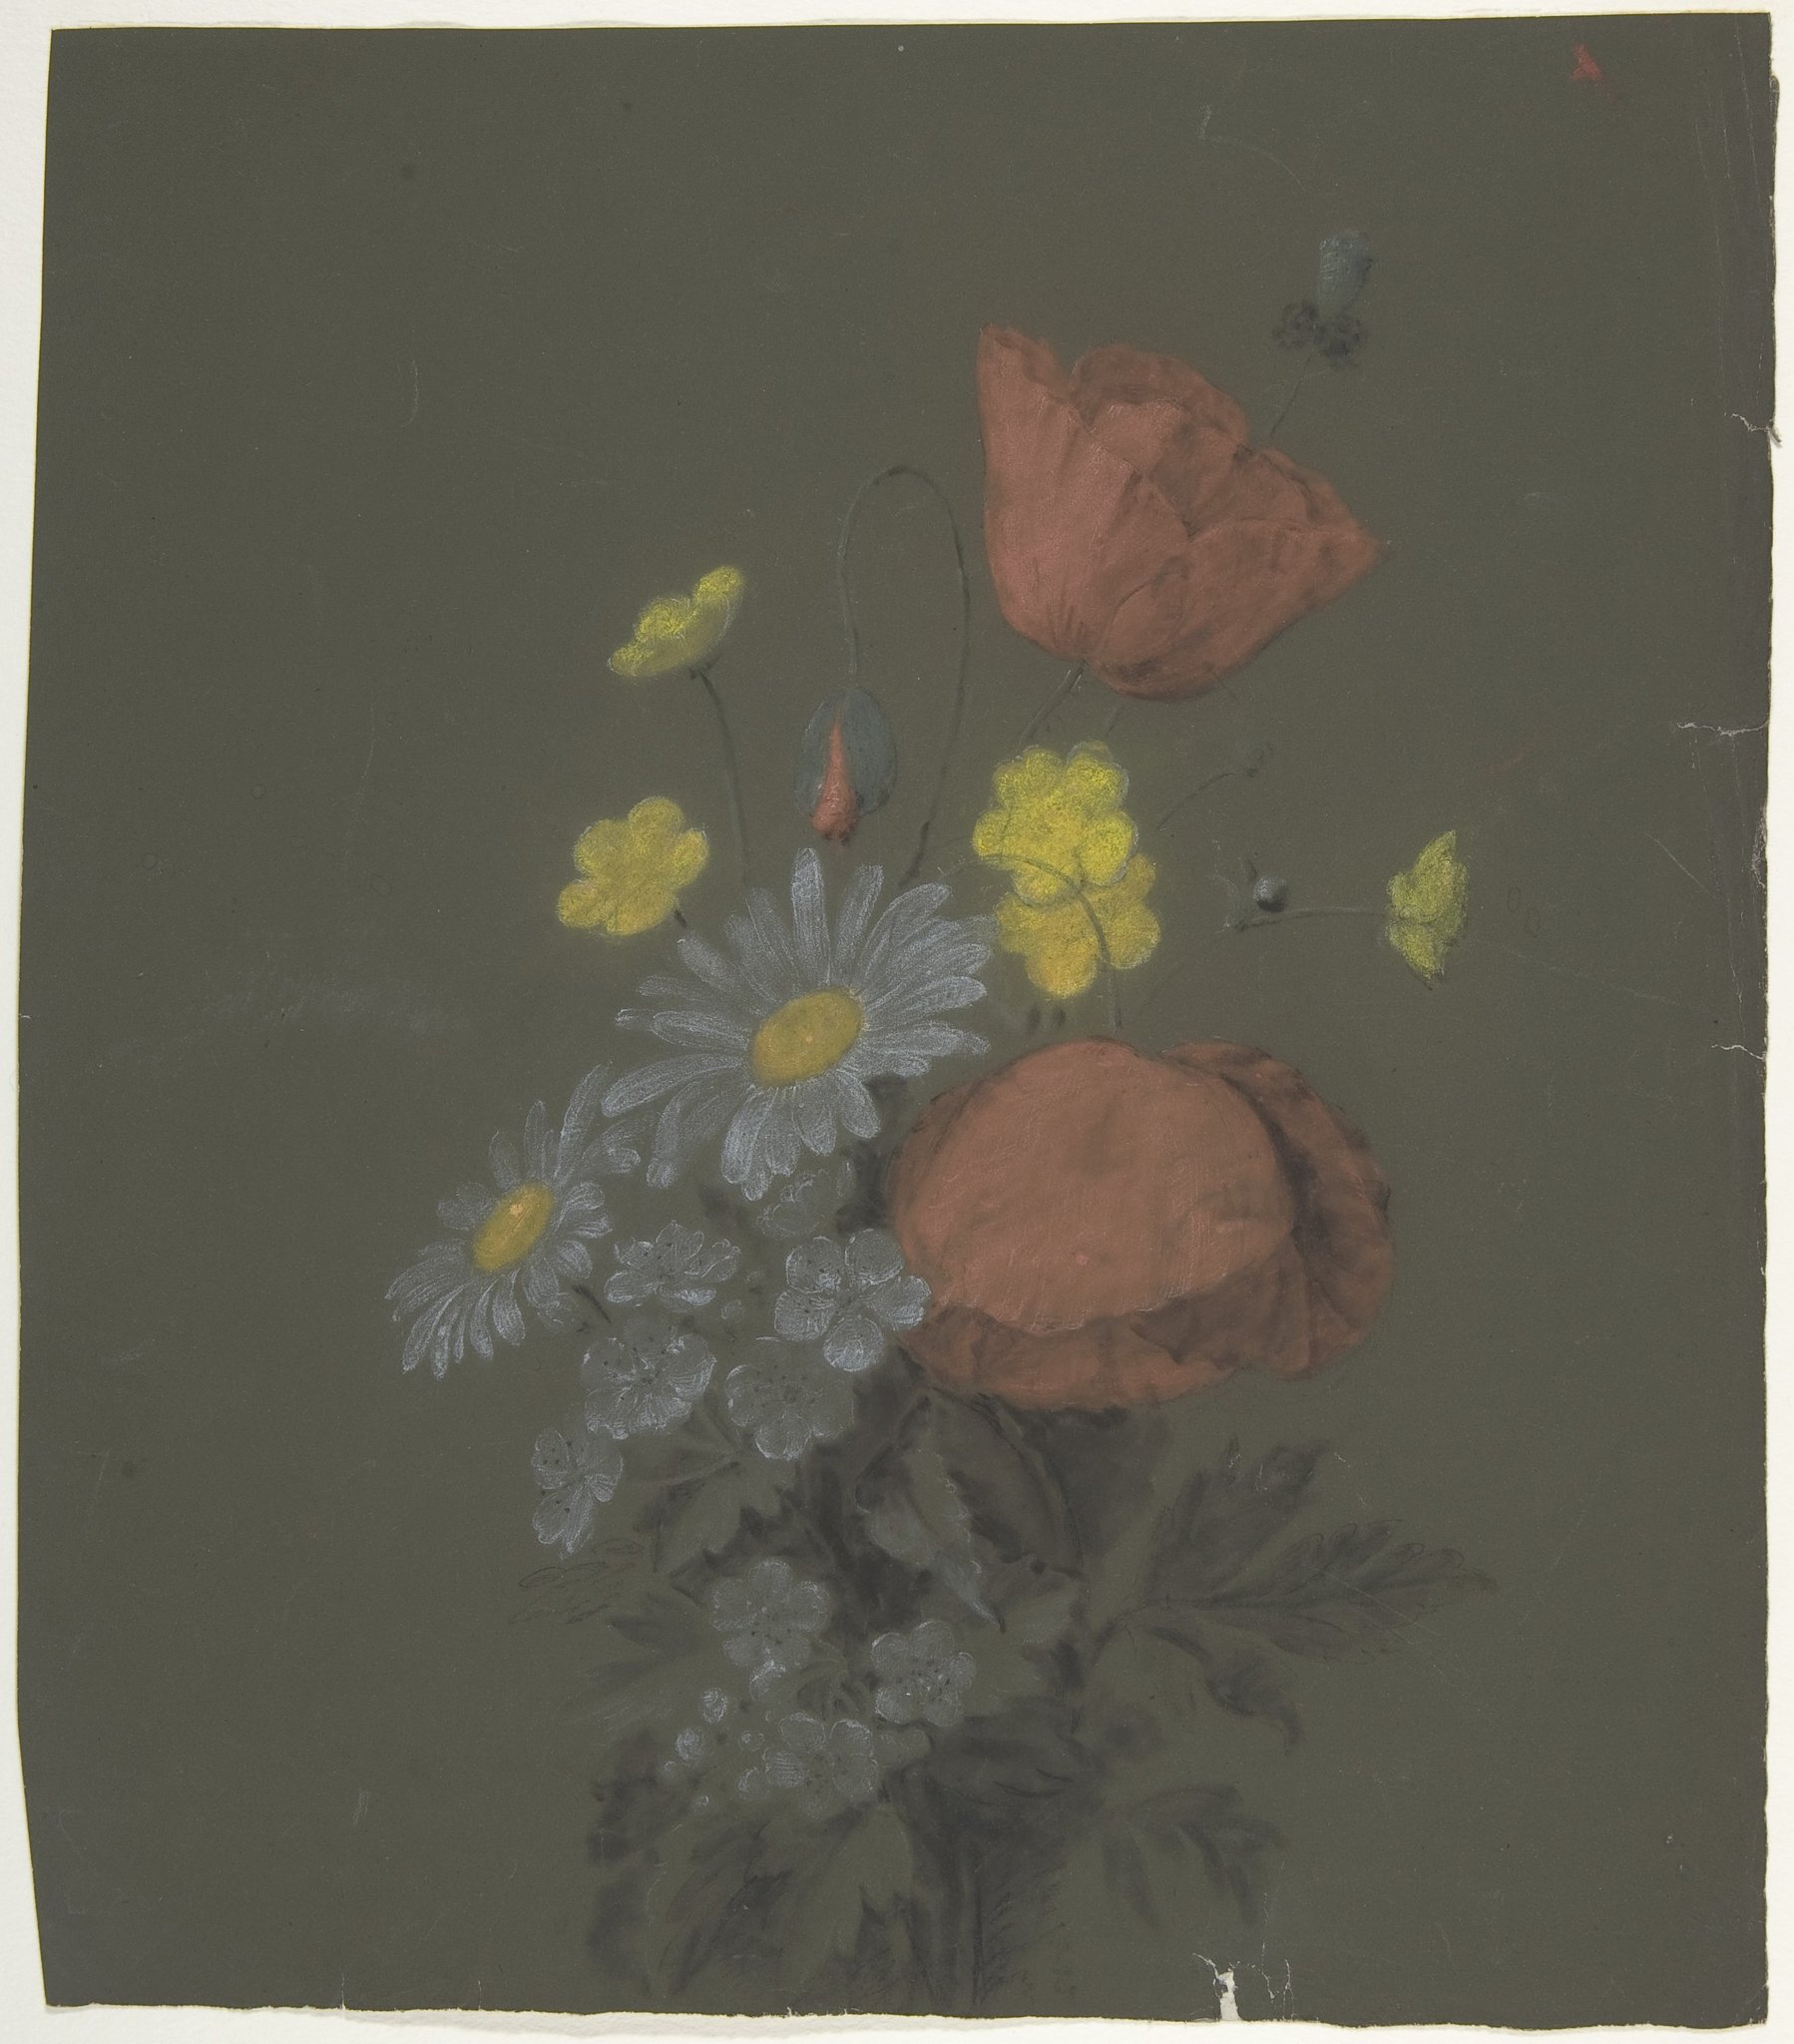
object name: drawing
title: Floral Design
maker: antoine berjon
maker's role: artist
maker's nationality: french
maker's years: 1754-1843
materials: chalk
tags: flowers